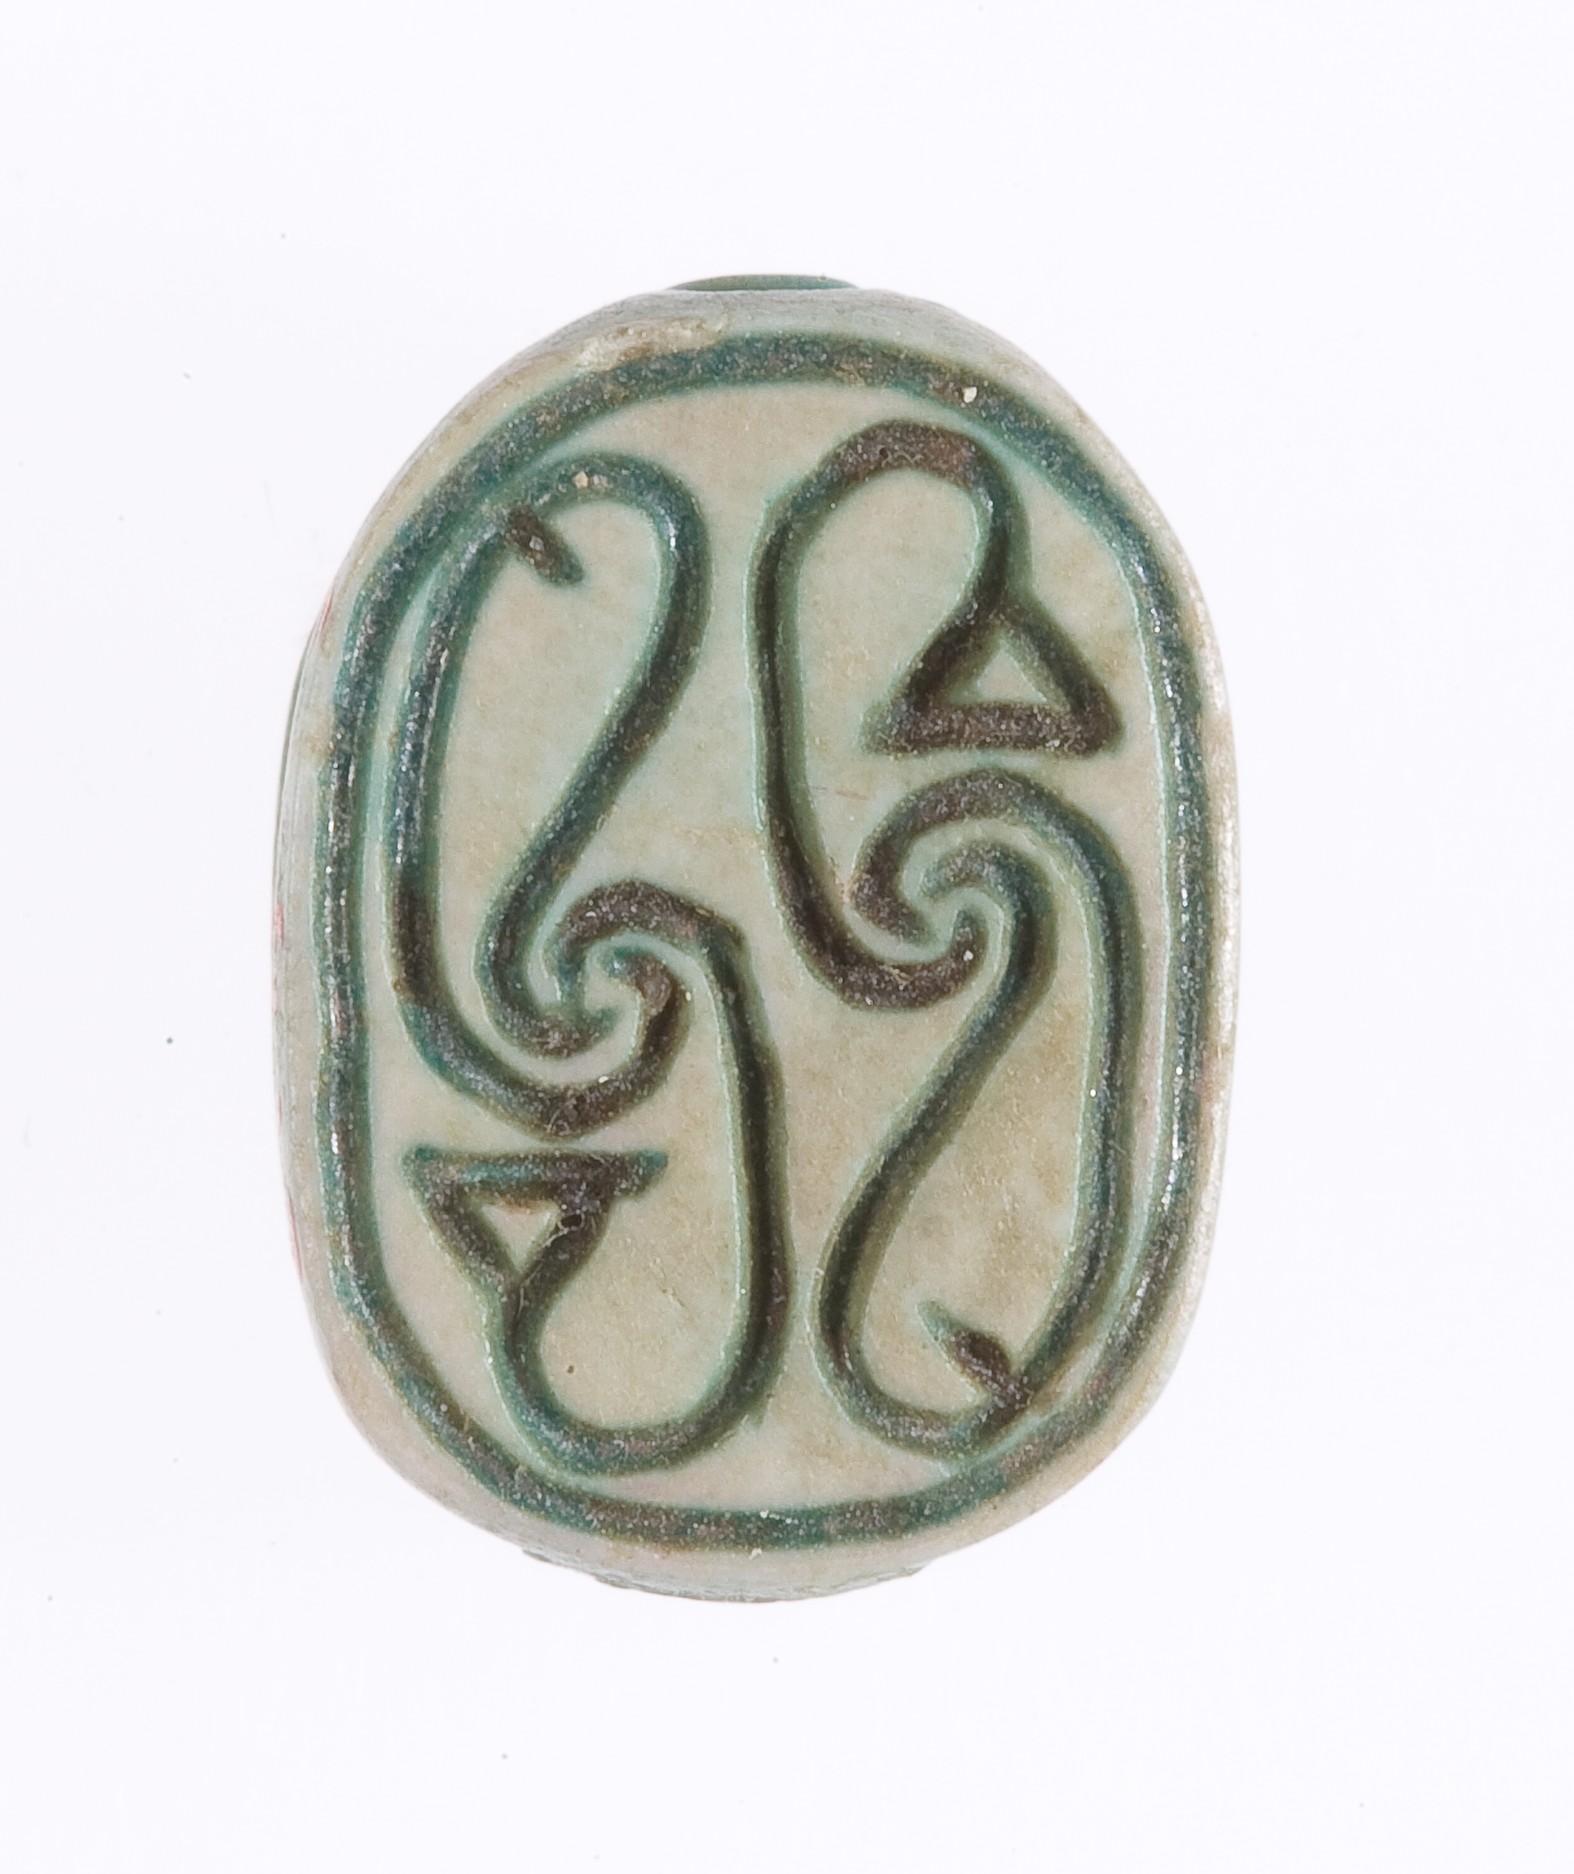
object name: scarab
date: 1991-1450 BCE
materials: stone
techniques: glazing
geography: egypt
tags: scarabs